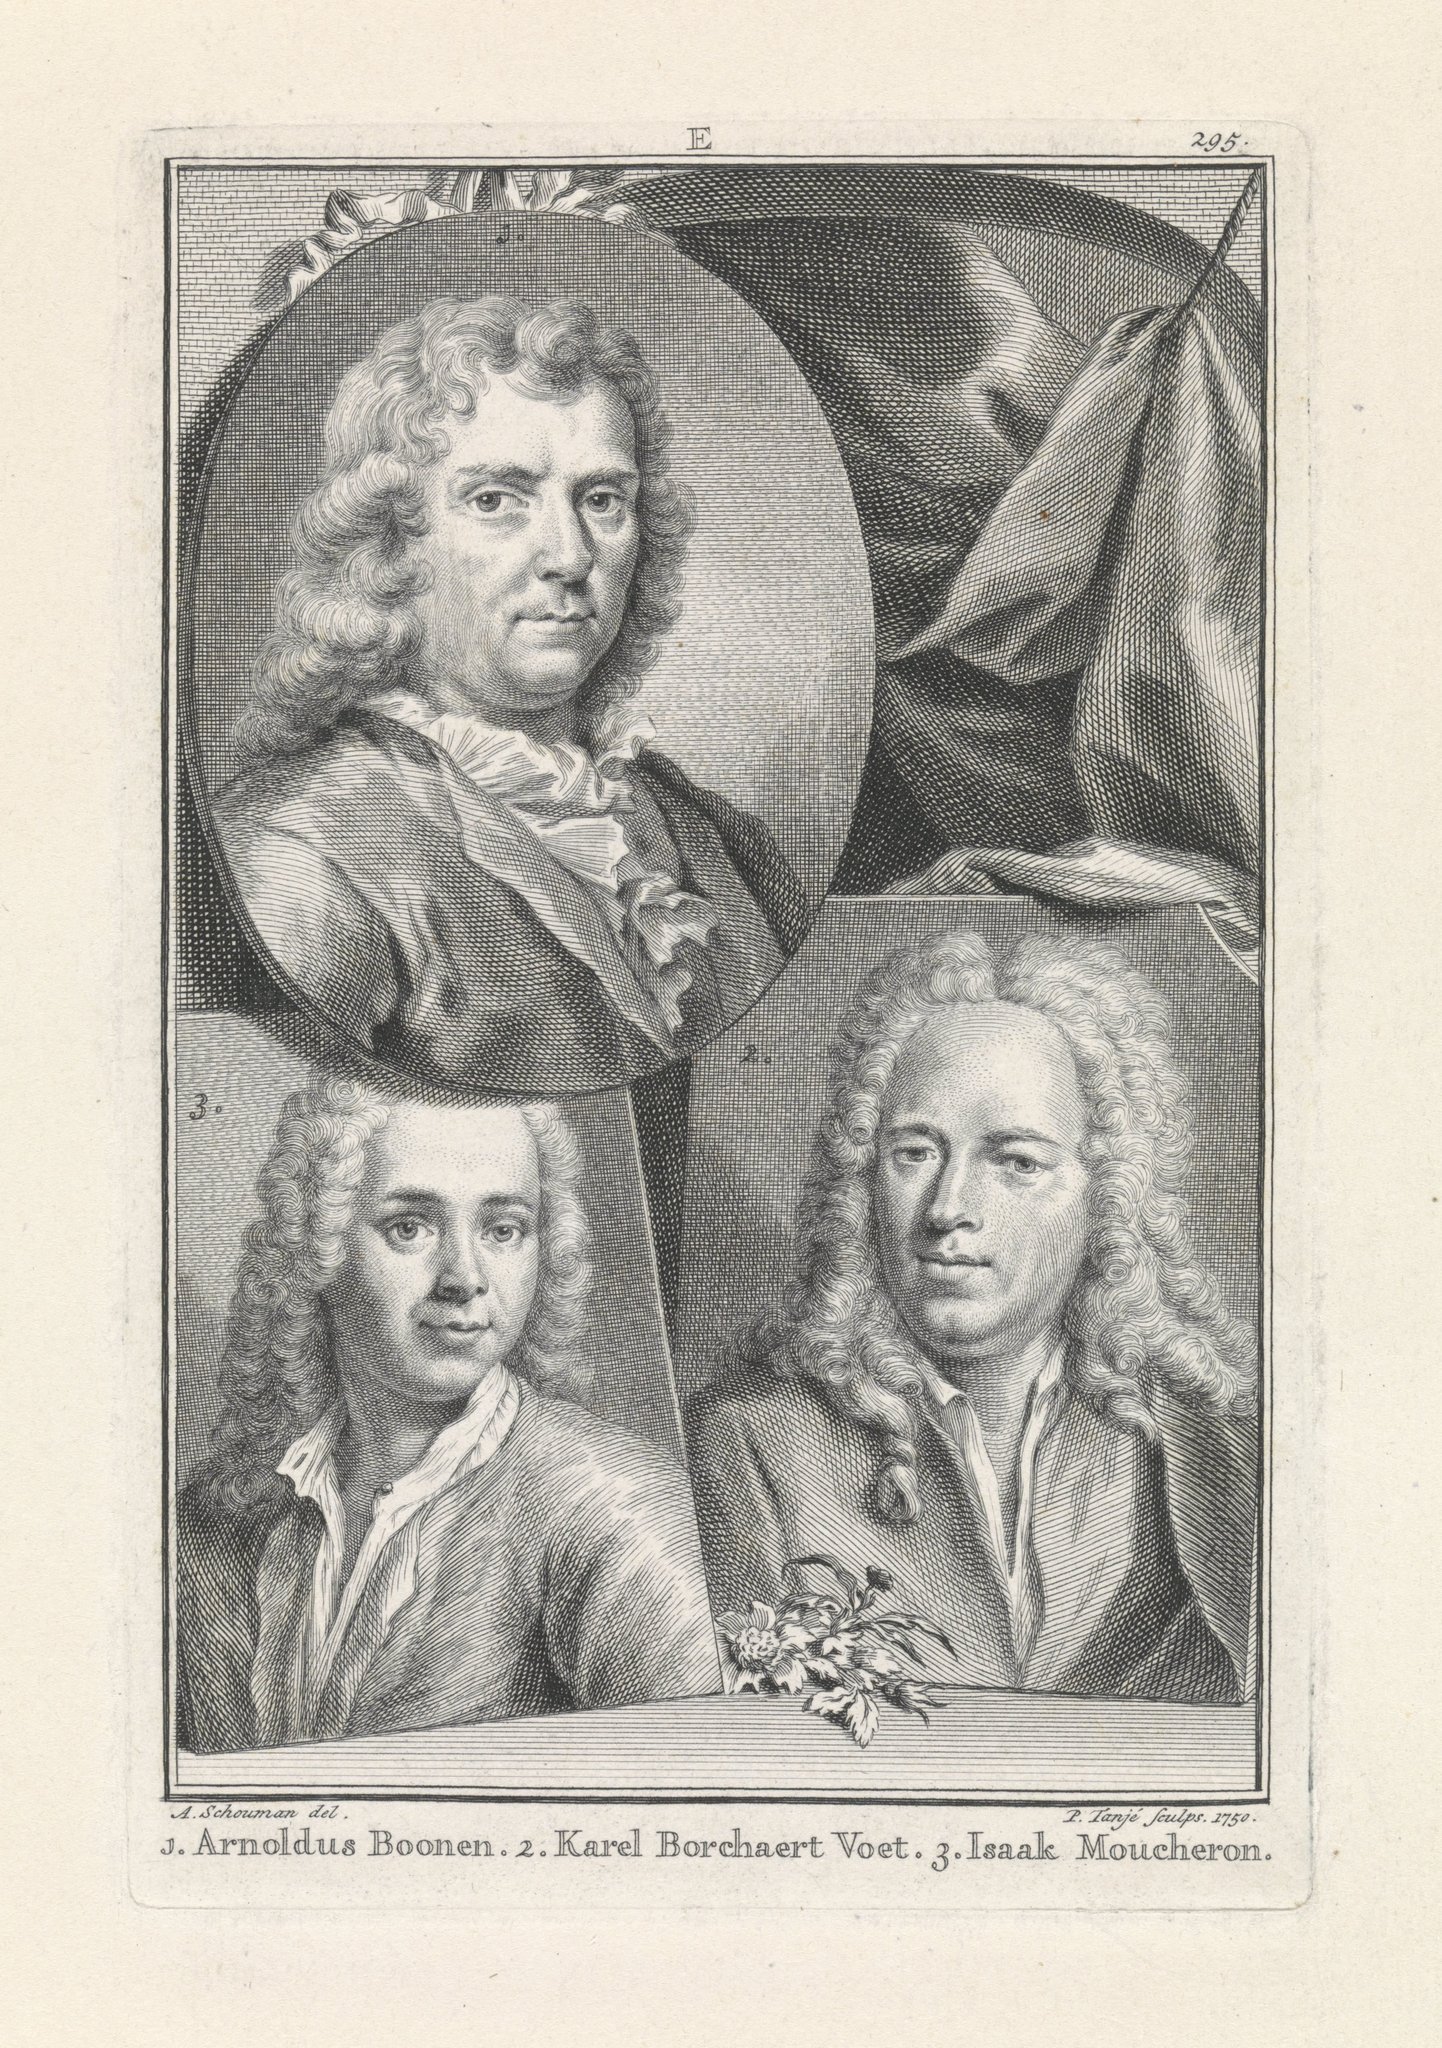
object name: book illustration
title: Portretten van Arnold Boonen, Carel Borchaert Voet en Isaac de Moucheron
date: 1750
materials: paper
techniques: engraving, etching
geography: amsterdam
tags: carel borchaert voet, amsterdam, painter, print maker, draughtsman, isaac de moucheron, arnold boonen, portrait, self-portrait of artist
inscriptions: collector's mark: Lugt 240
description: Prent uit: Gool, Johan van. De nieuwe schouburg der Nederlantsche kunstschilders en schilderessen. Den Haag 1750, dl. 1, p. 295.